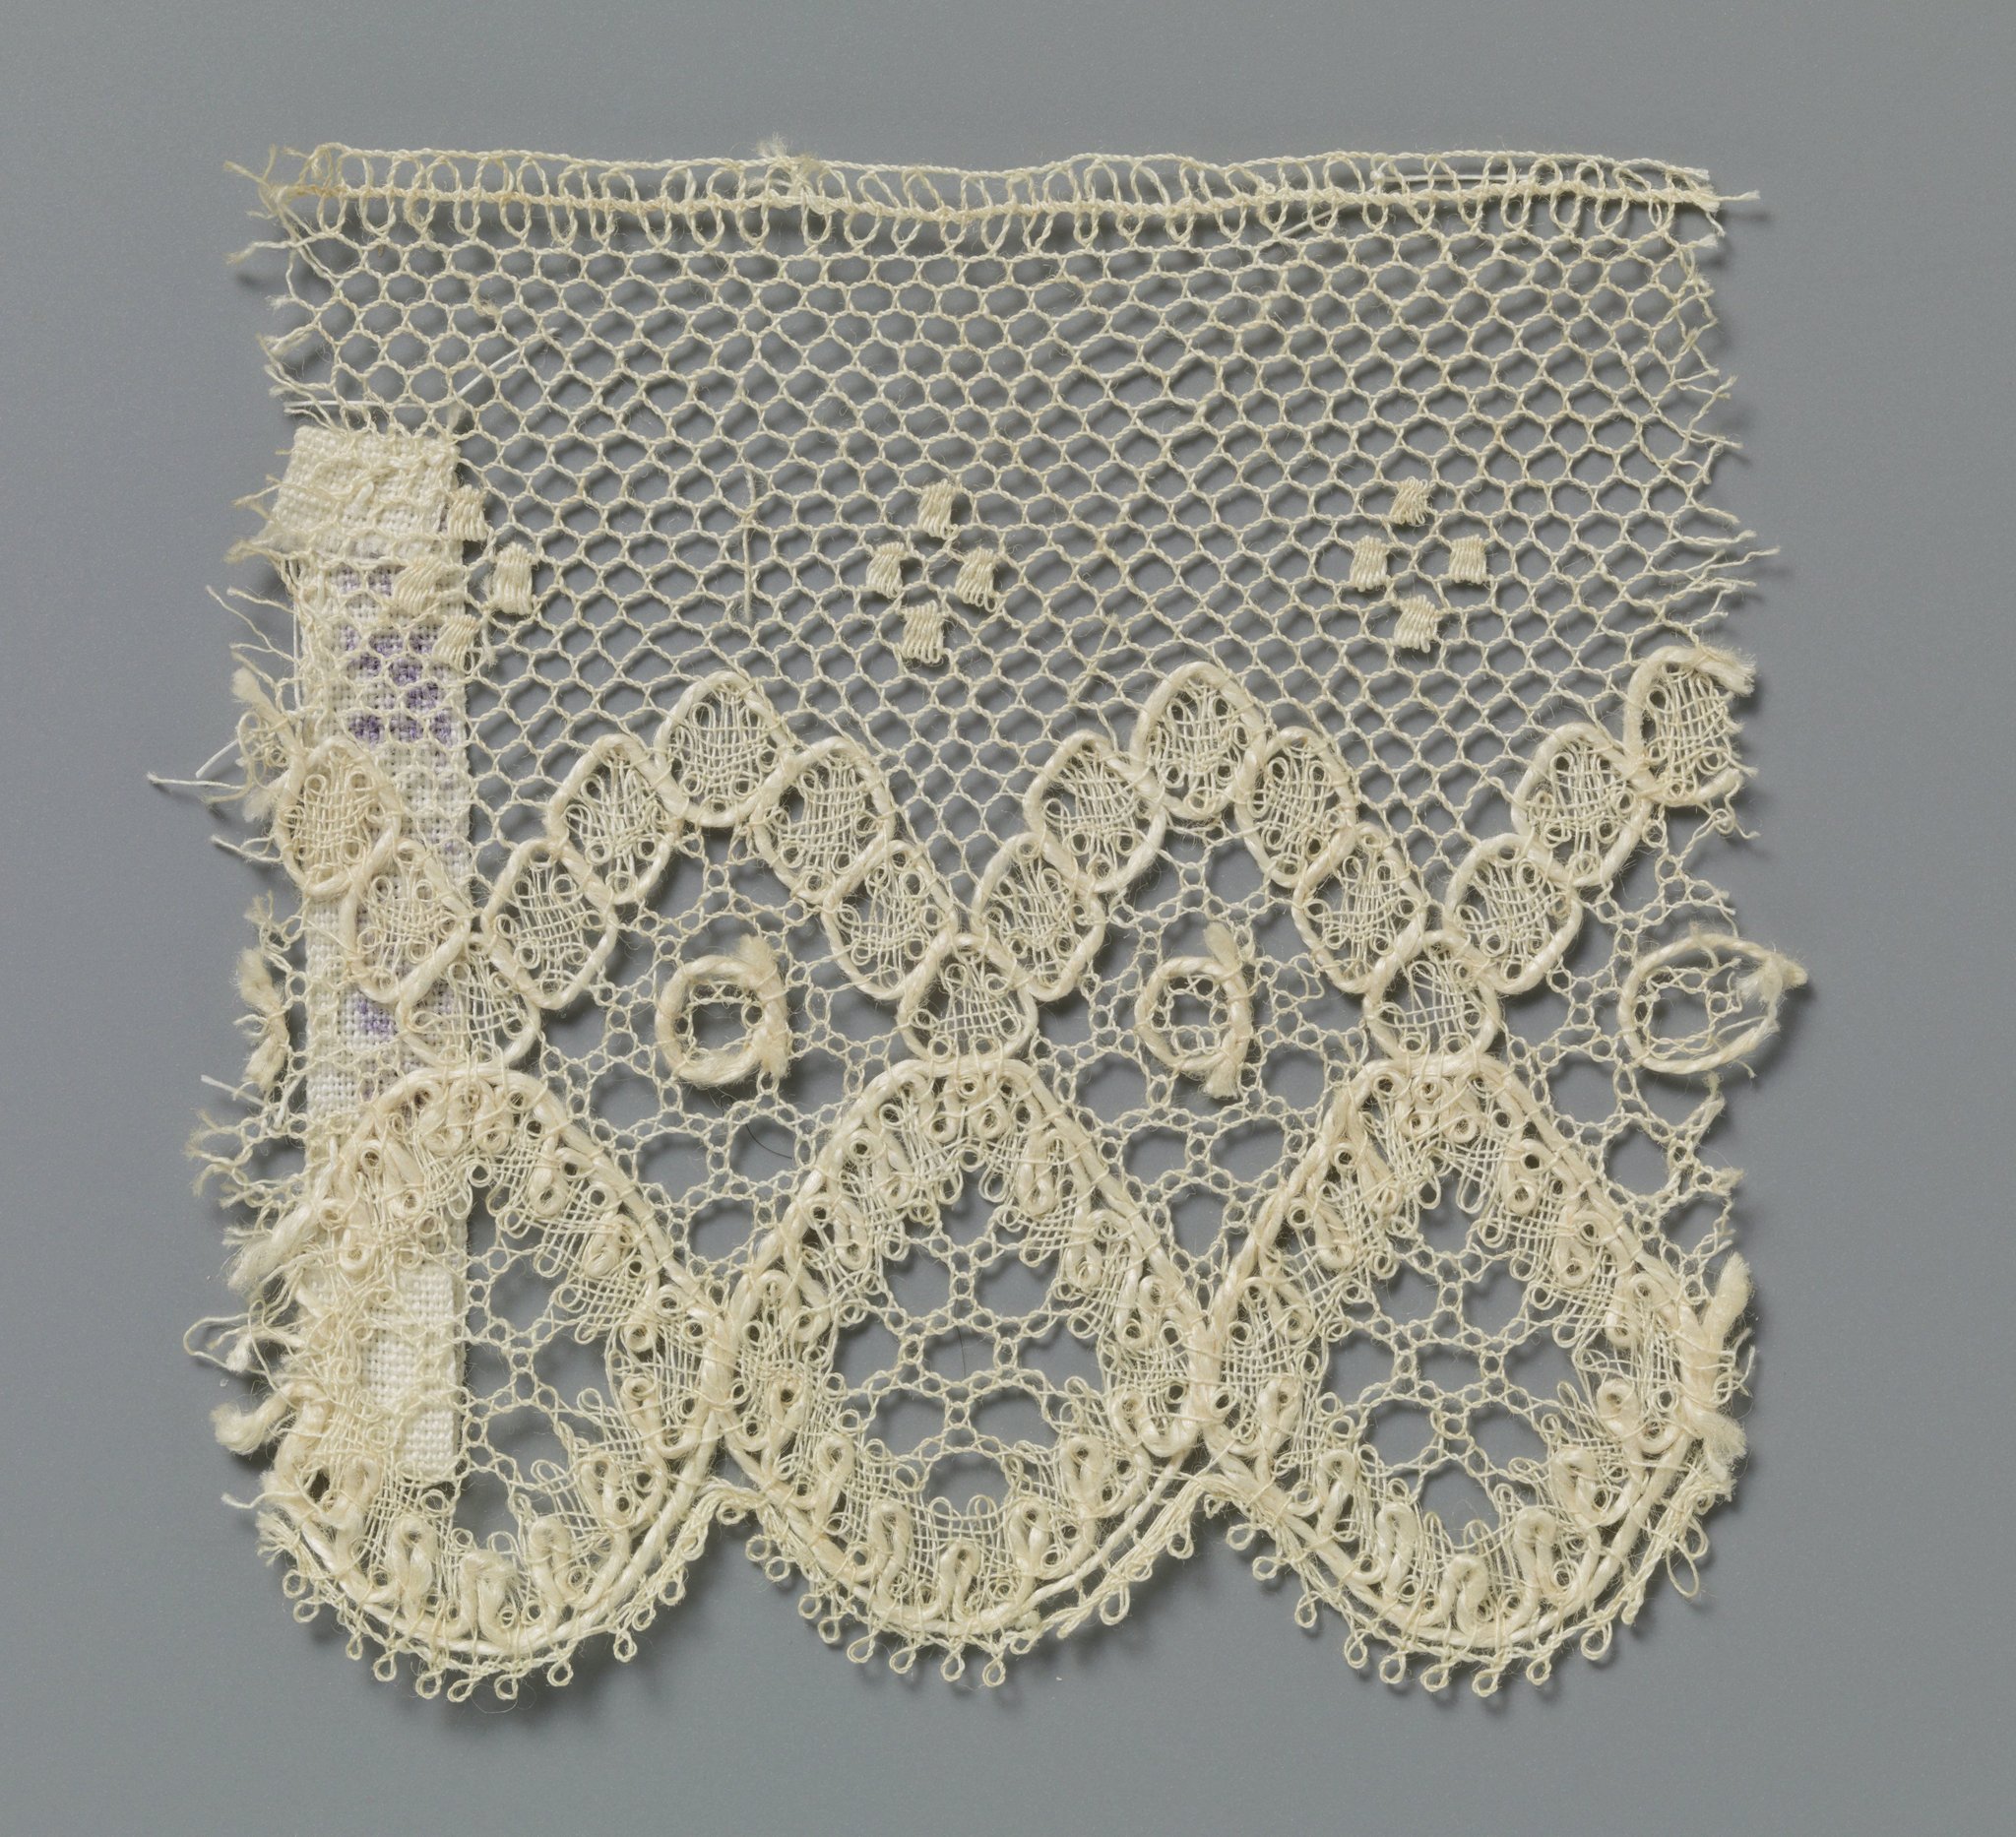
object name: strip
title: Strook kloskant met druppels onder een zigzag-lijn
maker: Anonymous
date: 1800-1899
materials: cotton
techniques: lace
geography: buckingham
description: Strook naturelkleurige kloskant, Buckingham-kant. Het zich herhalende patroon bestaat over het midden van de strook uit een zigzag-lijn van aaneengeschakelde ruitjes. Onder elke zigzag hangt een druppelvormige cartouche. Boven de zigzag-lijn bestaat de strook uit een maasgrond, een tulegrond, met boven elke zigzag viervoudige moesjes. De moesjes zijn gemaakt in vormslag. Onder de zigzag-lijn is een siergrond toegepast, een rozengrond. De ruitjes in de zigzag en de omlijstingen van de druppels zijn gemaakt in linnenslag met dikke en glimmende contourdraden. Om de buitenzijde van de druppels is een dubbele contourdraad gebruikt, waarbij de binnenste van de twee draden lusjes maakt door het linnenwerk heen. De bovenzijde van de strook is recht afgewerkt. De schulpenrand langs de onderzijde komt voort uit de druppelvormige cartouches en is afgewerkt met picots.